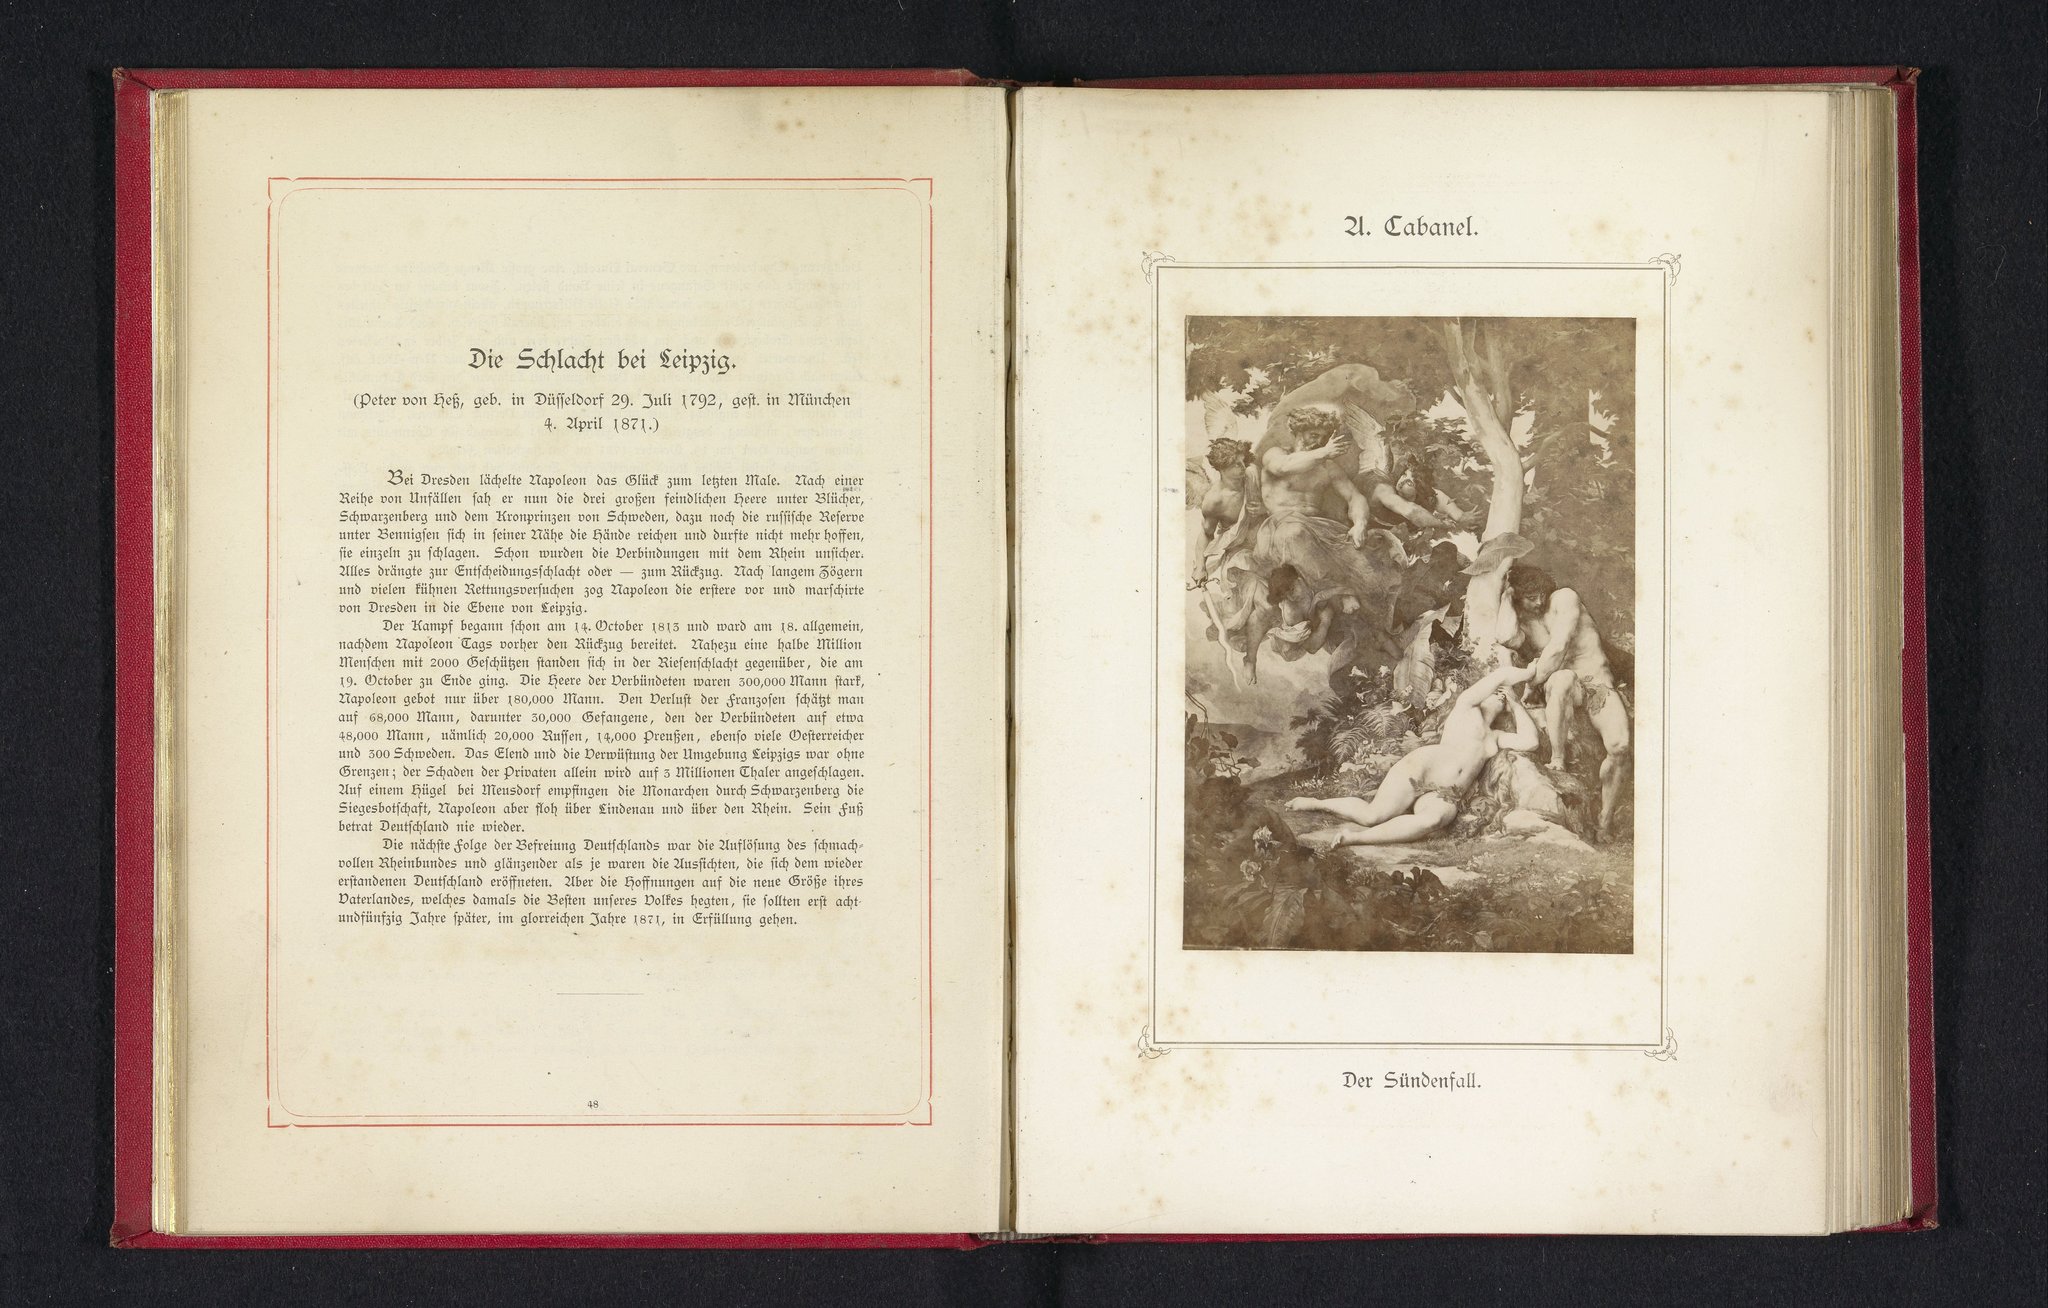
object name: photograph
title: Der Sündenfall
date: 1875-1880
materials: photographic support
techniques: albumen print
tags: expulsion of adam and eve from paradise (genesis 3:22-24)